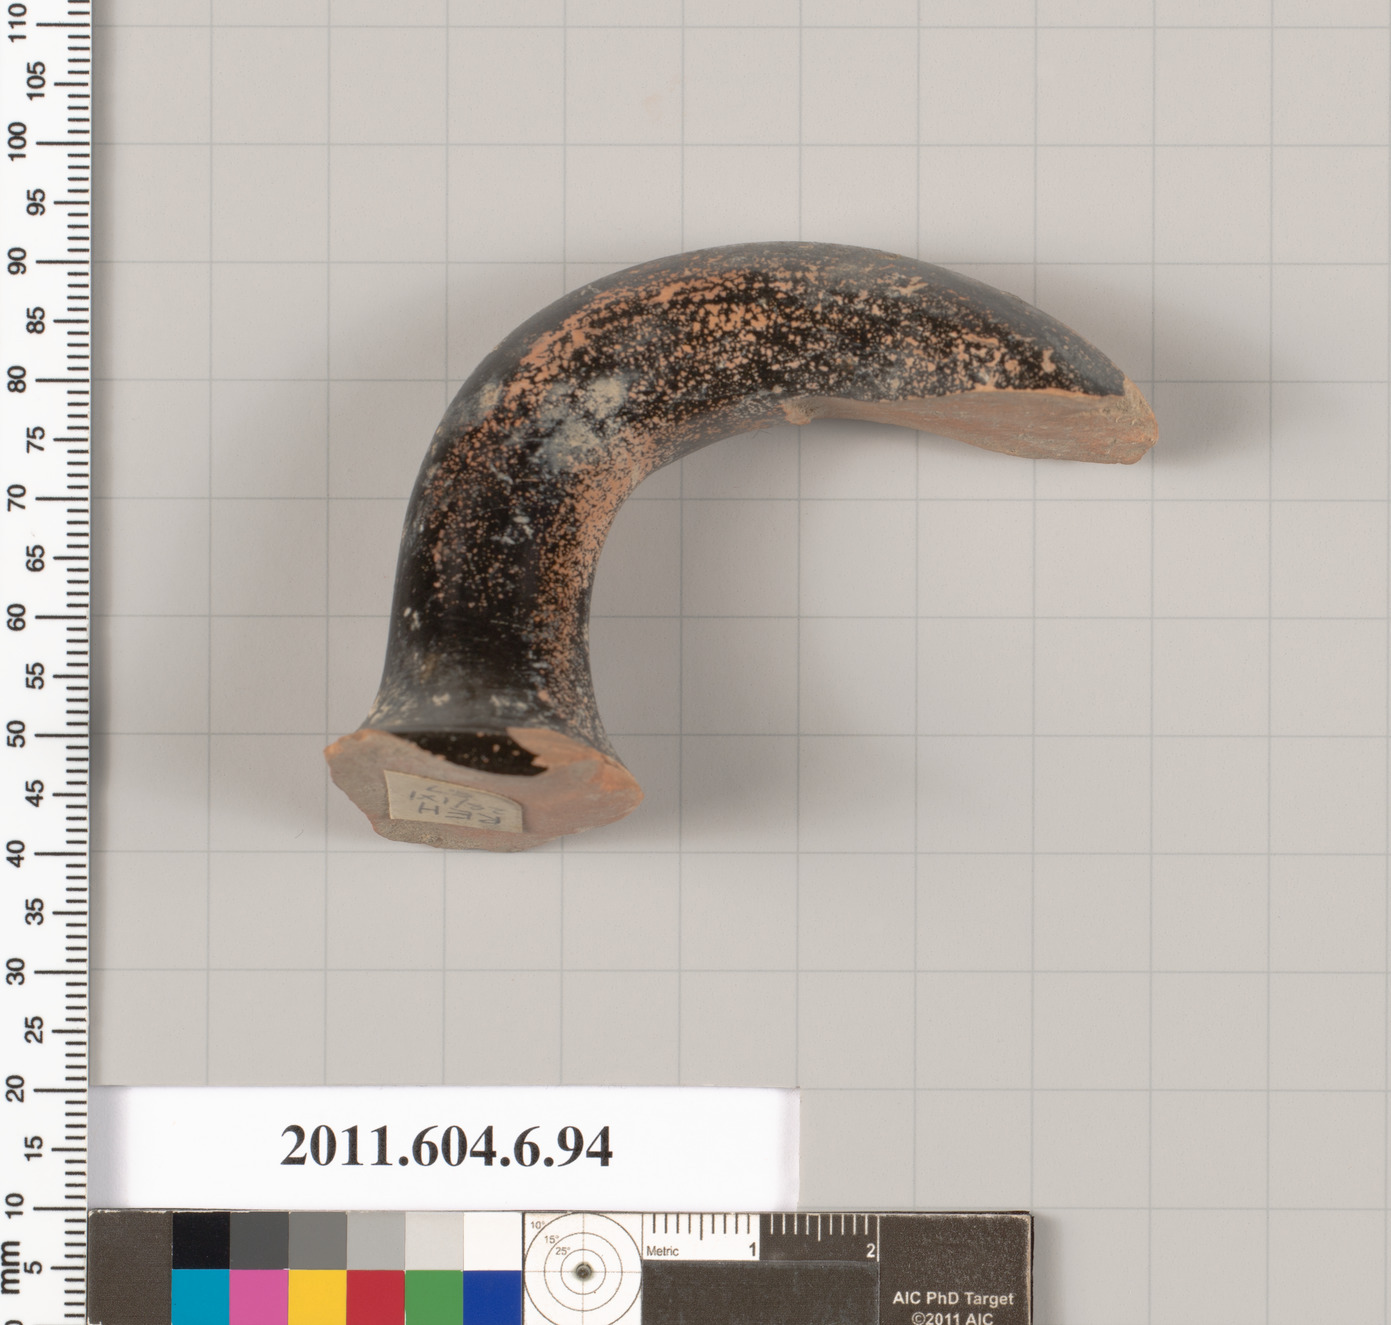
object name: skyphos fragment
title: Terracotta fragment of a skyphos (deep drinking cup)?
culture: greek, attic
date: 500-401 BCE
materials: terracotta